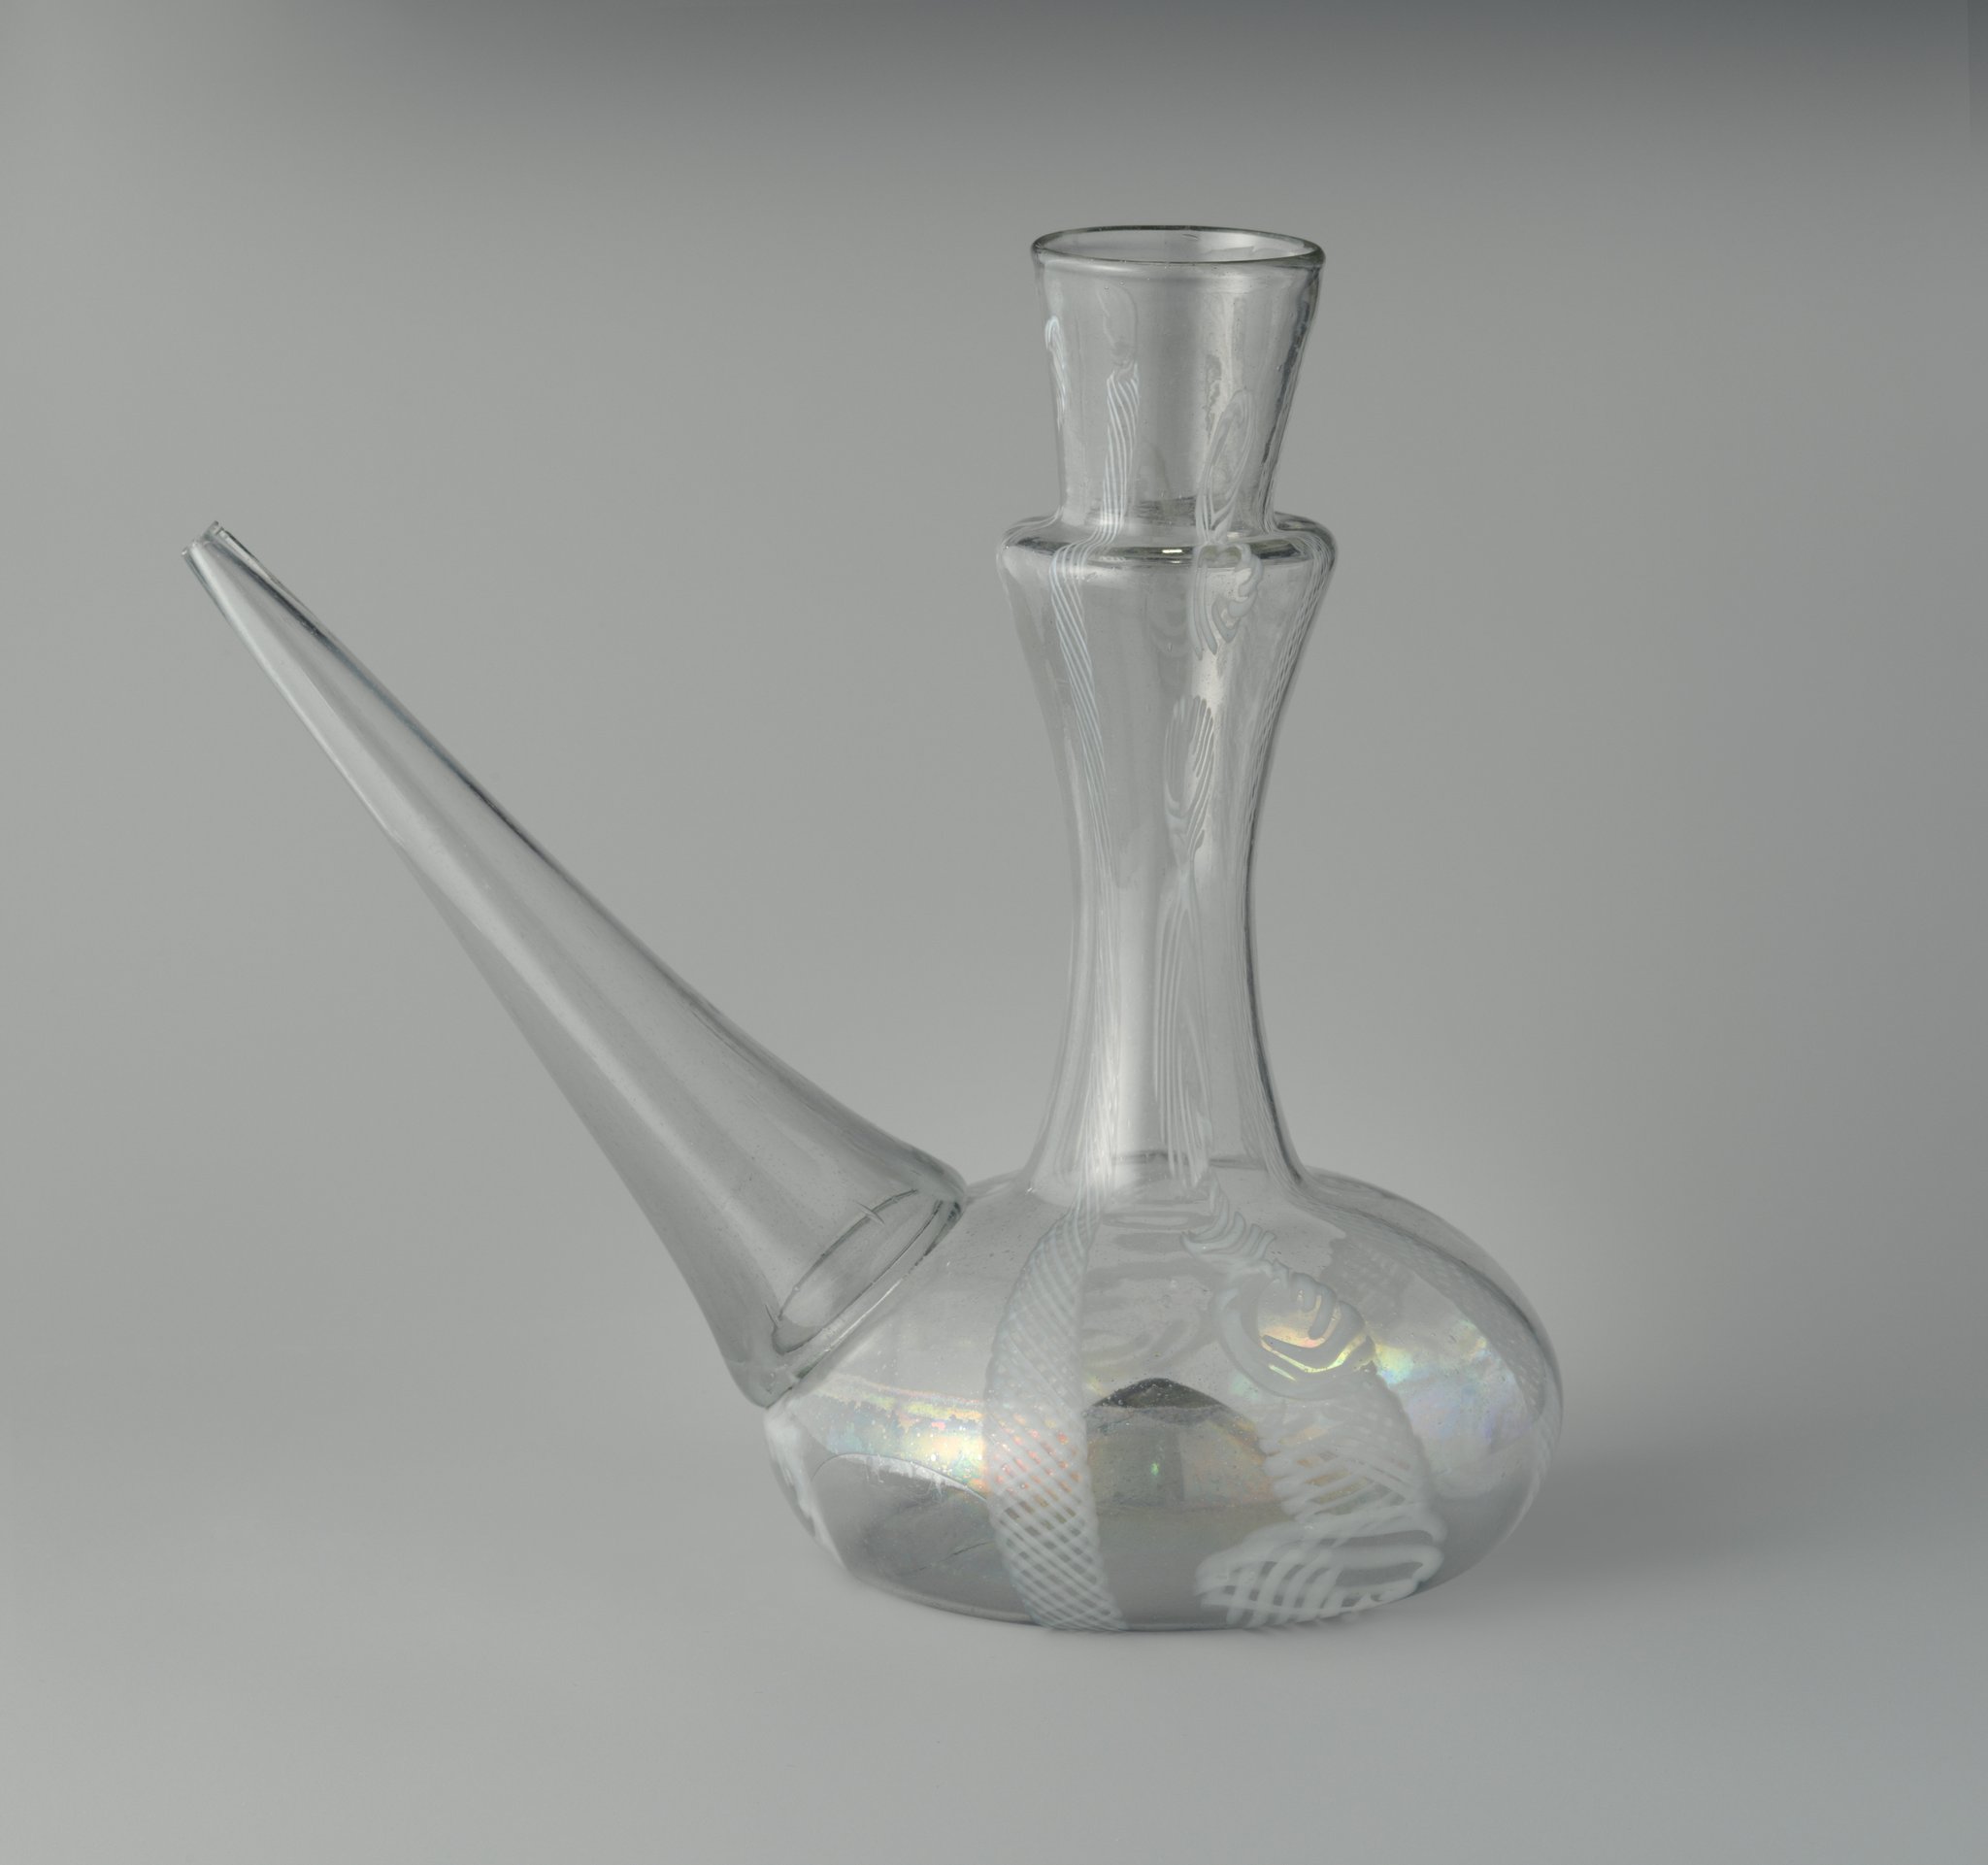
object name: drinking bottle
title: Drinking bottle (Porrón)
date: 1701-1800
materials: glass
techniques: glassblowing